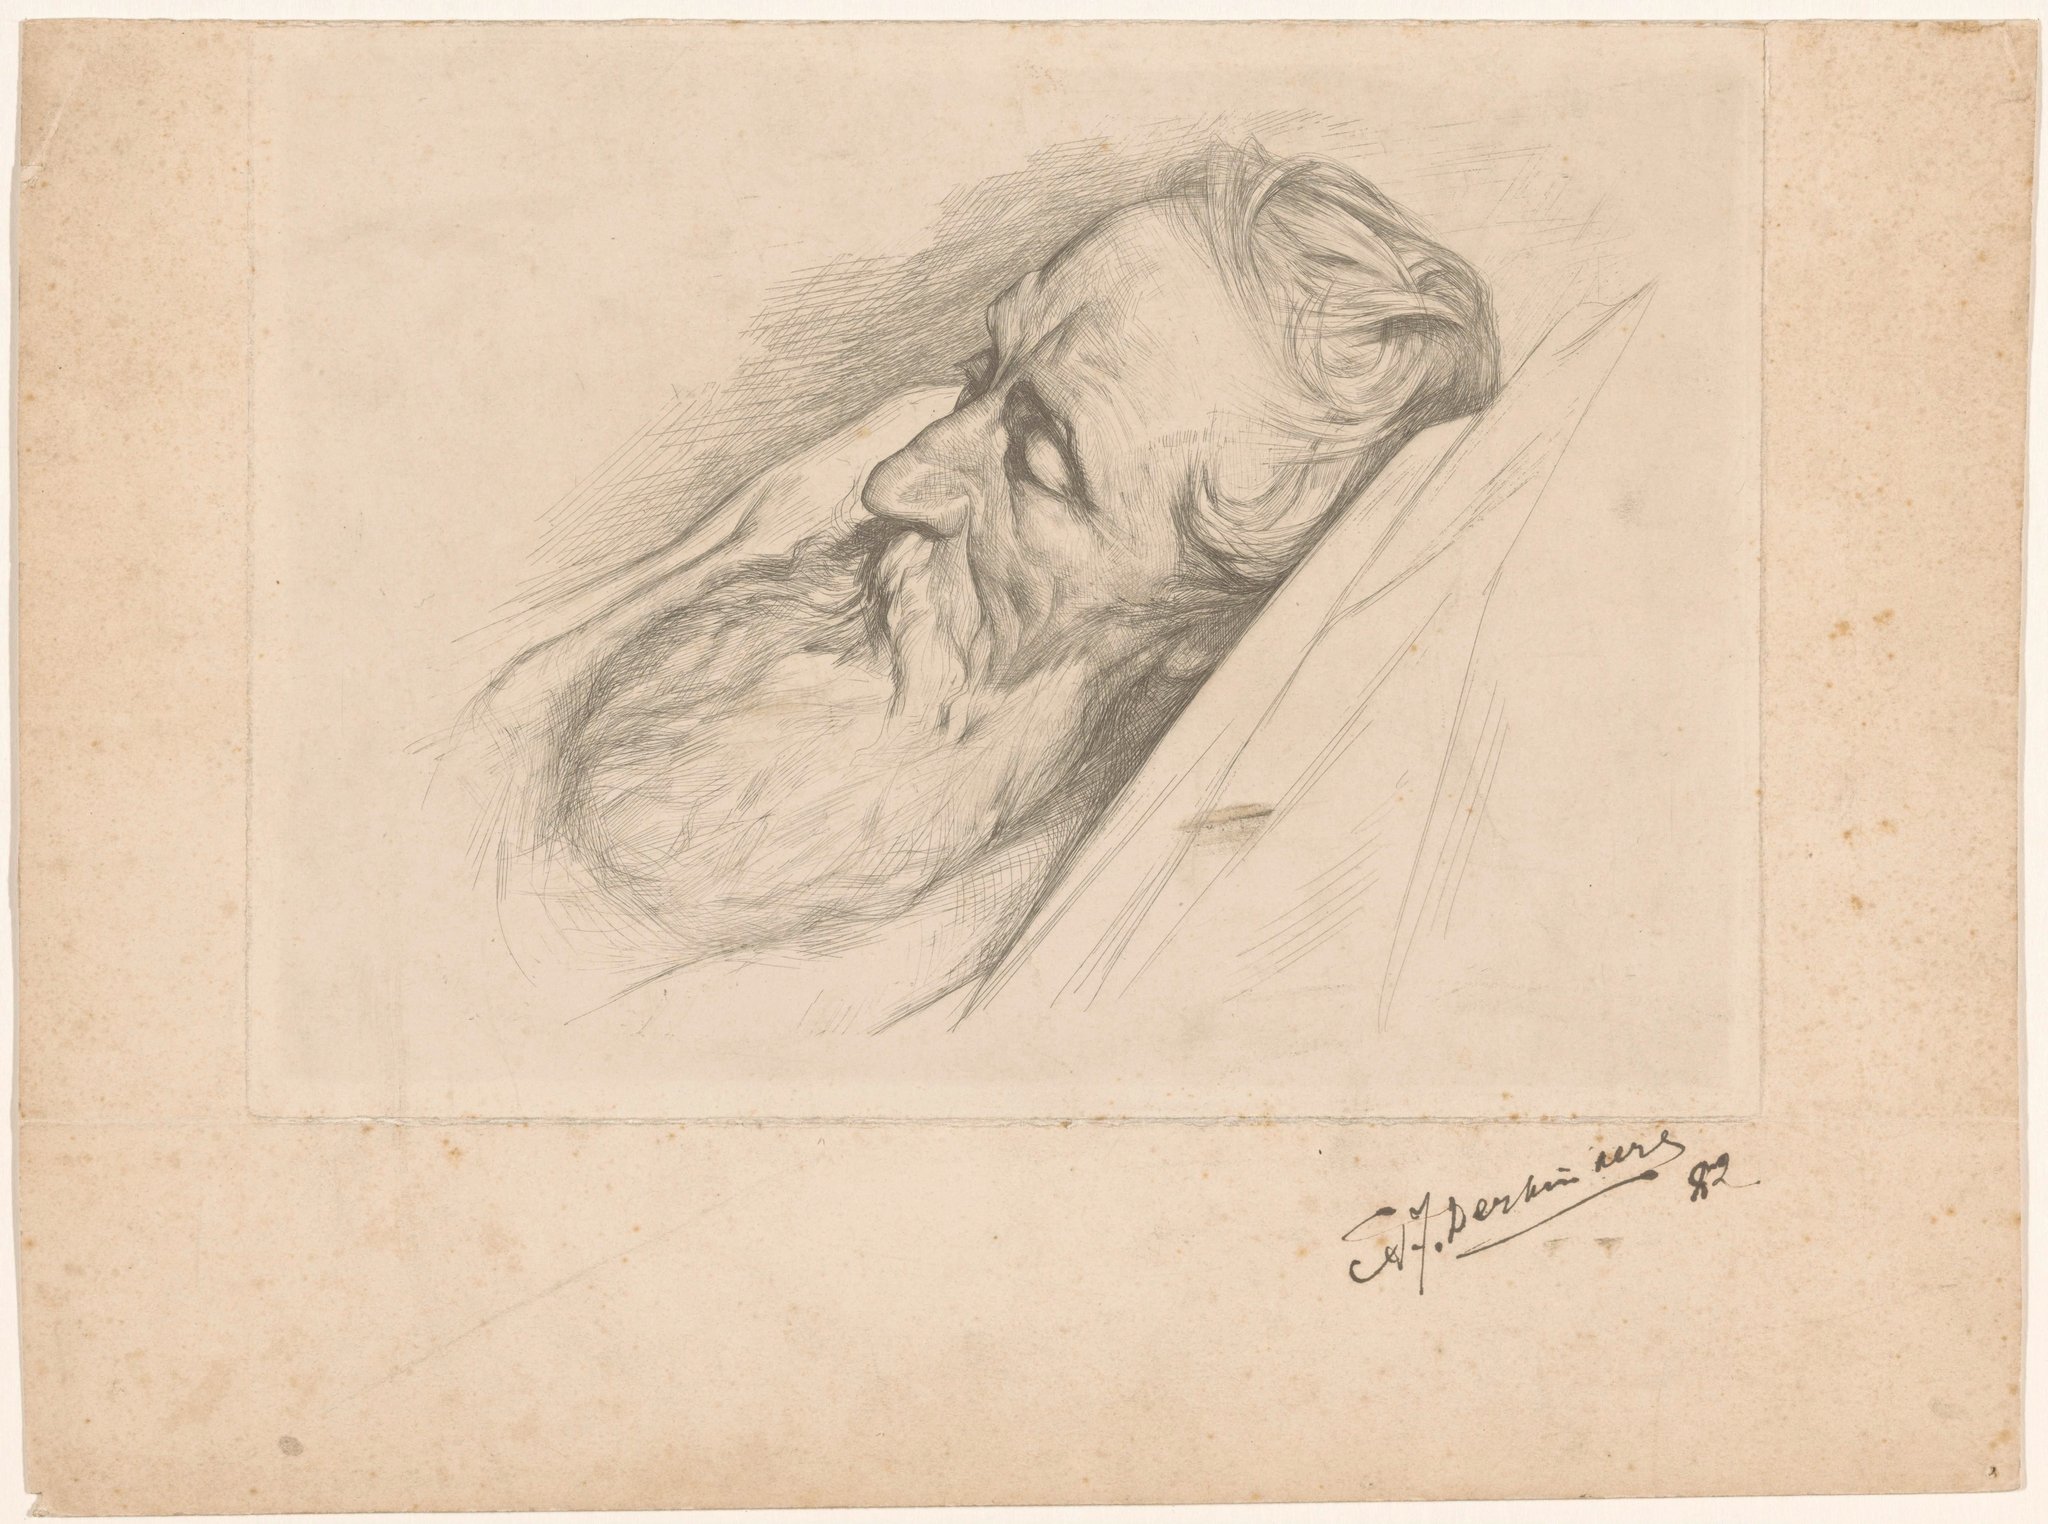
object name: print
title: Slapende man met baard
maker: antoon derkinderen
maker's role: draughtsman, painter, print maker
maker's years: 1859-1925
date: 1882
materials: paper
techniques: etching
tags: sleeping; unconsciousness, beard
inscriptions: collector's mark: Lugt 2228